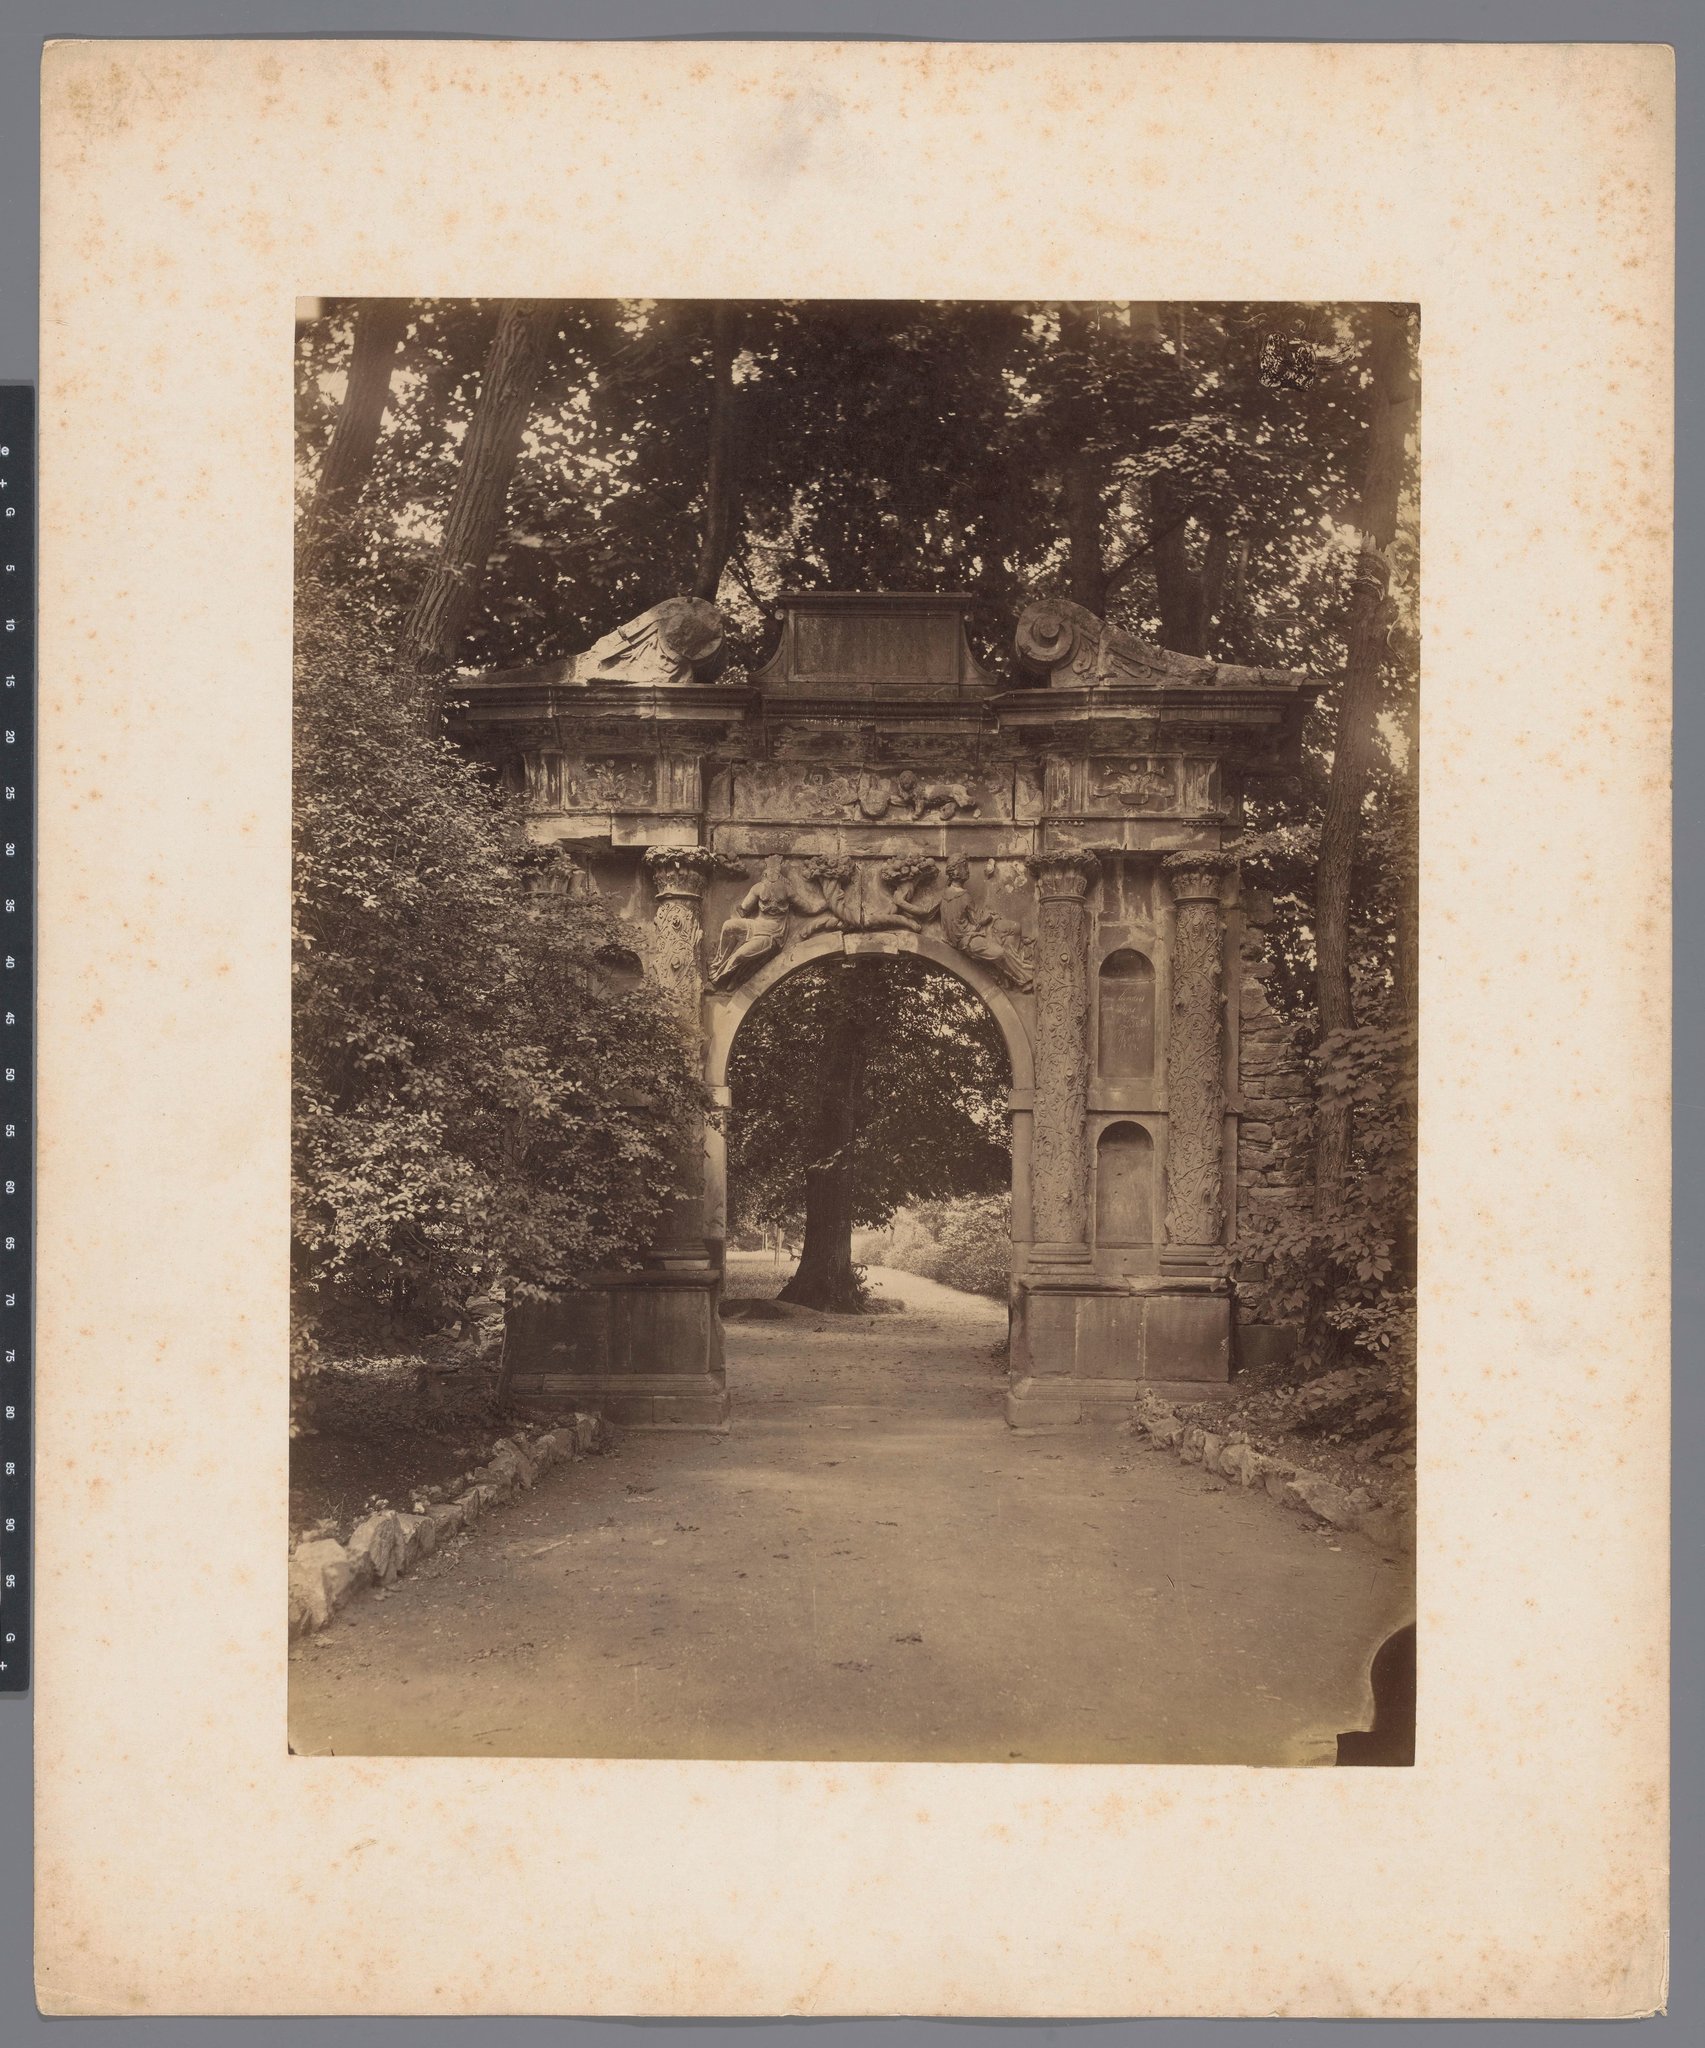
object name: photograph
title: Elizabethspoort bij Schloss Heidelberg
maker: Anonymous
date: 1883-1900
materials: cardboard, paper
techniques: albumen print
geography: heidelberg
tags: gate, entrance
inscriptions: inscription: ‘18 29 Juni/ Poort bij Heidelberger Schloss./ 18’